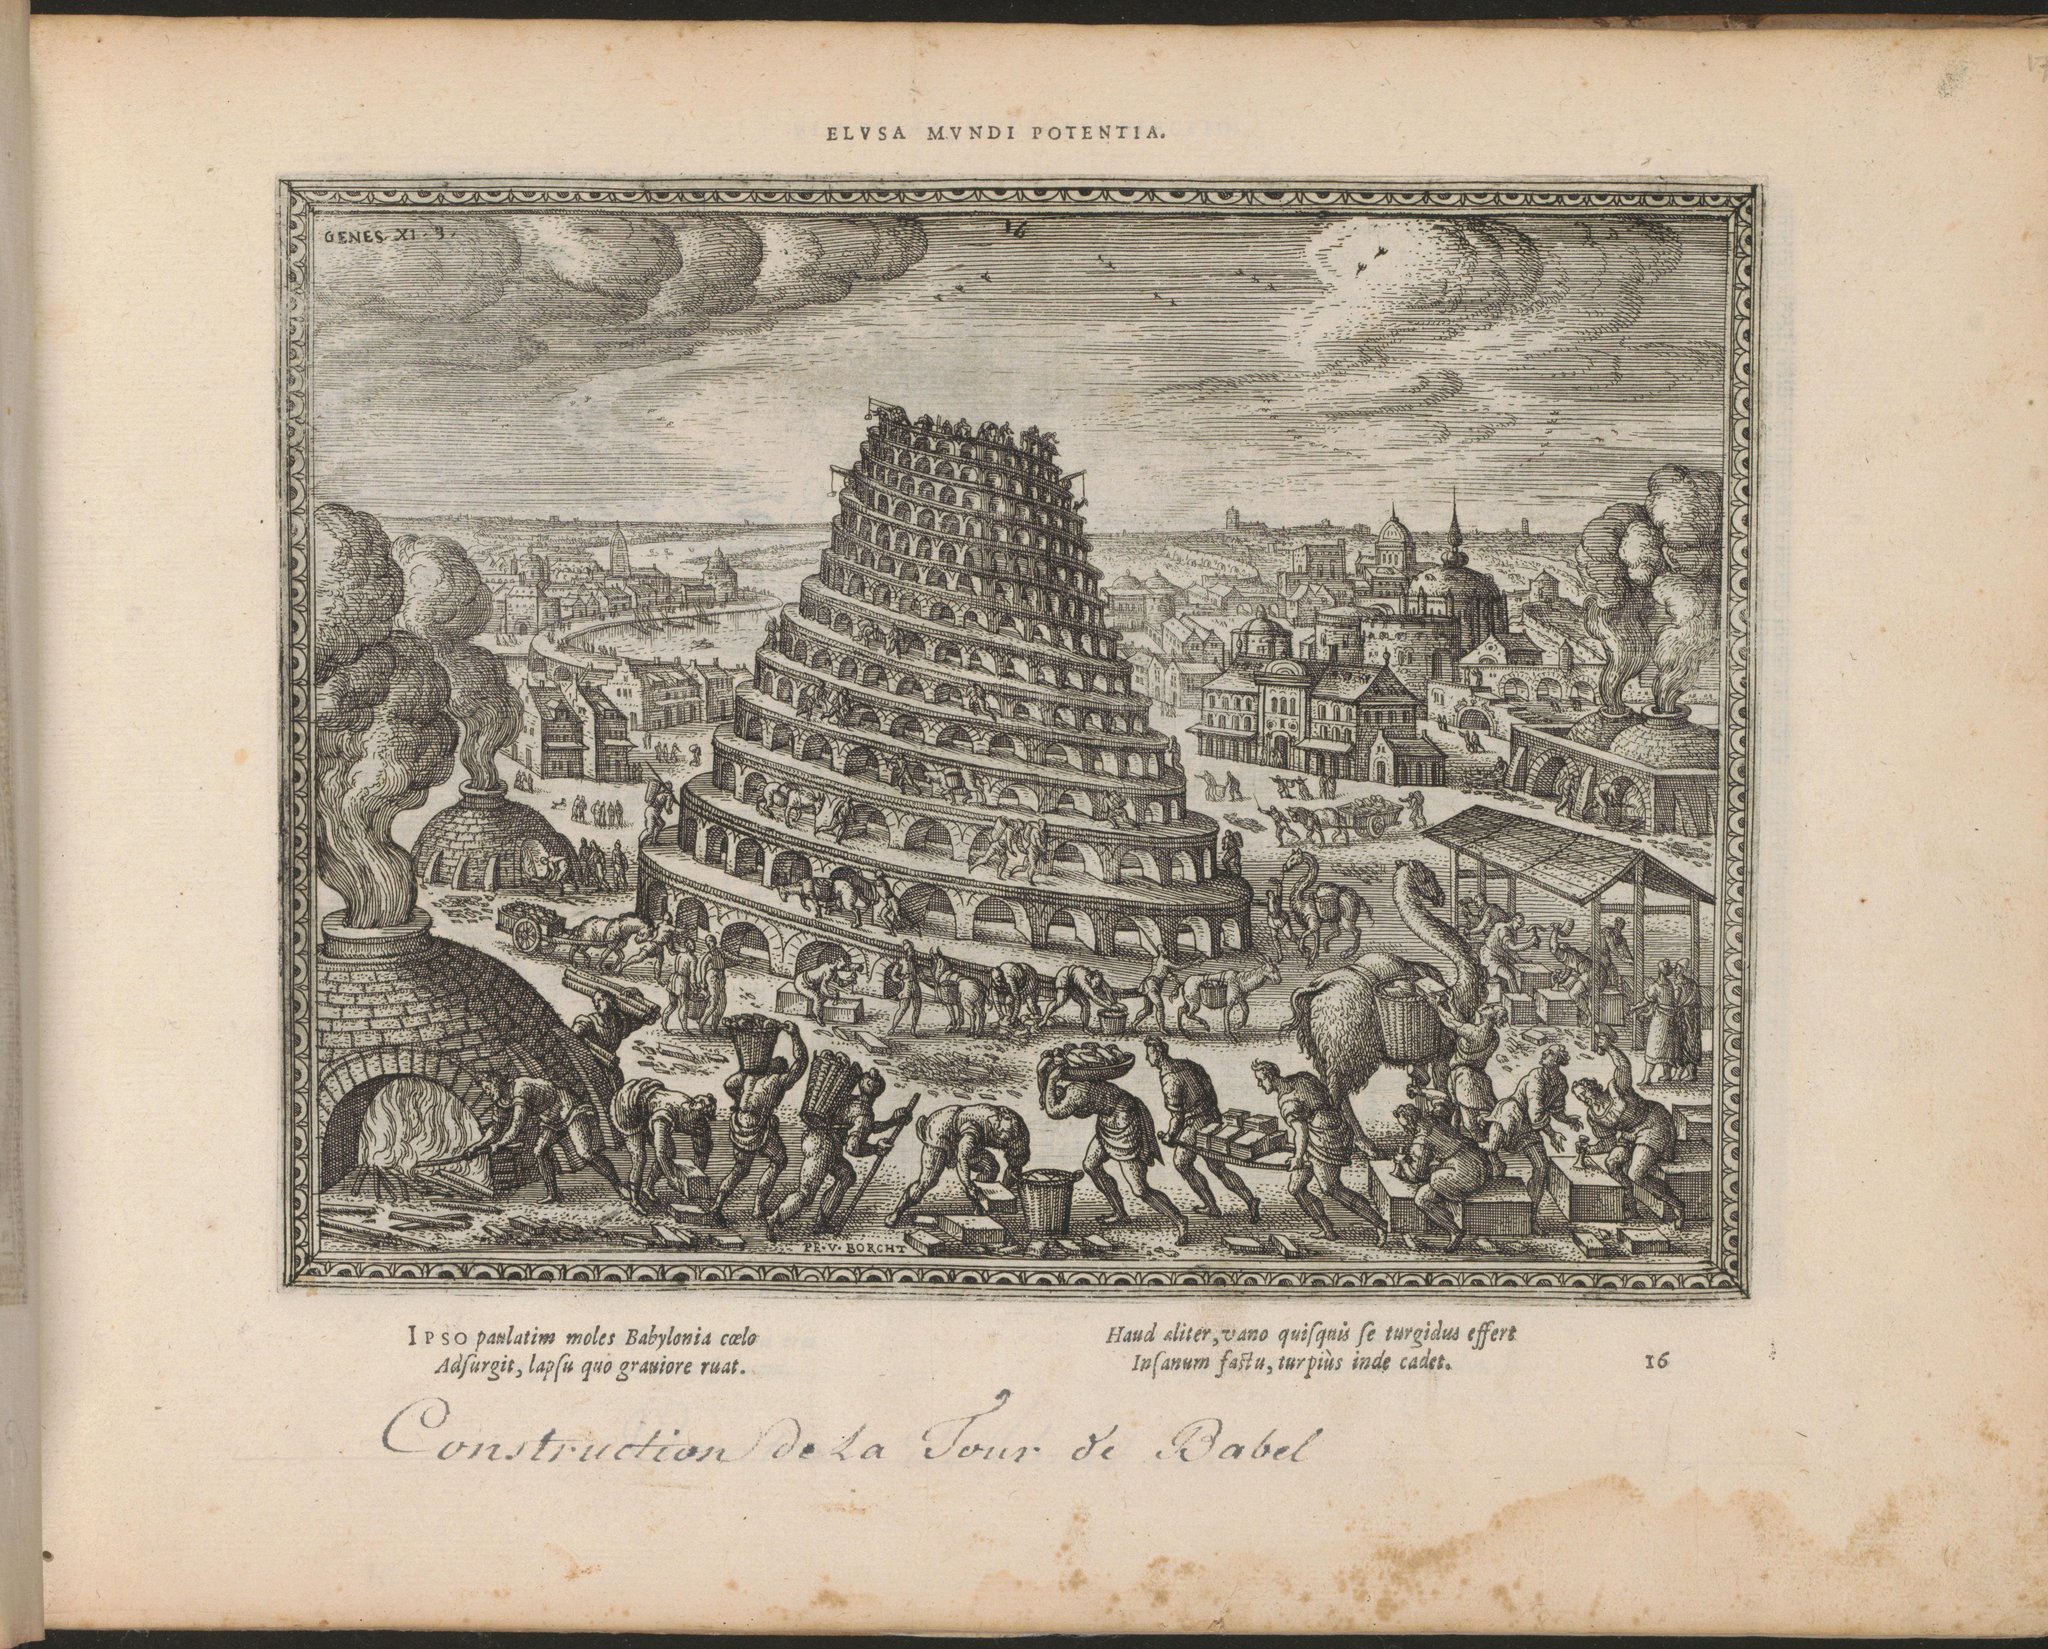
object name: album leaf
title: Toren van Babel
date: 1582-1593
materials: paper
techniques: etching, letterpress printing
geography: amsterdam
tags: transport of building materials, building activities, the tower of babel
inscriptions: inscription: ‘Construction de la Tour de Babel’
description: De bouw van de toren van Babel. Er zijn verschillende ovens te zien waarin de stenen worden gebakken. Rechts zijn enkele steenhouwers aan het werk, maar er zijn vele werklieden in de weer (Gen. 11:3-4). Met een motto in het Latijn boven de voorstelling en een vierregelig onderschrift in het Latijn onder de prent. De prent maakt deel uit van een album.